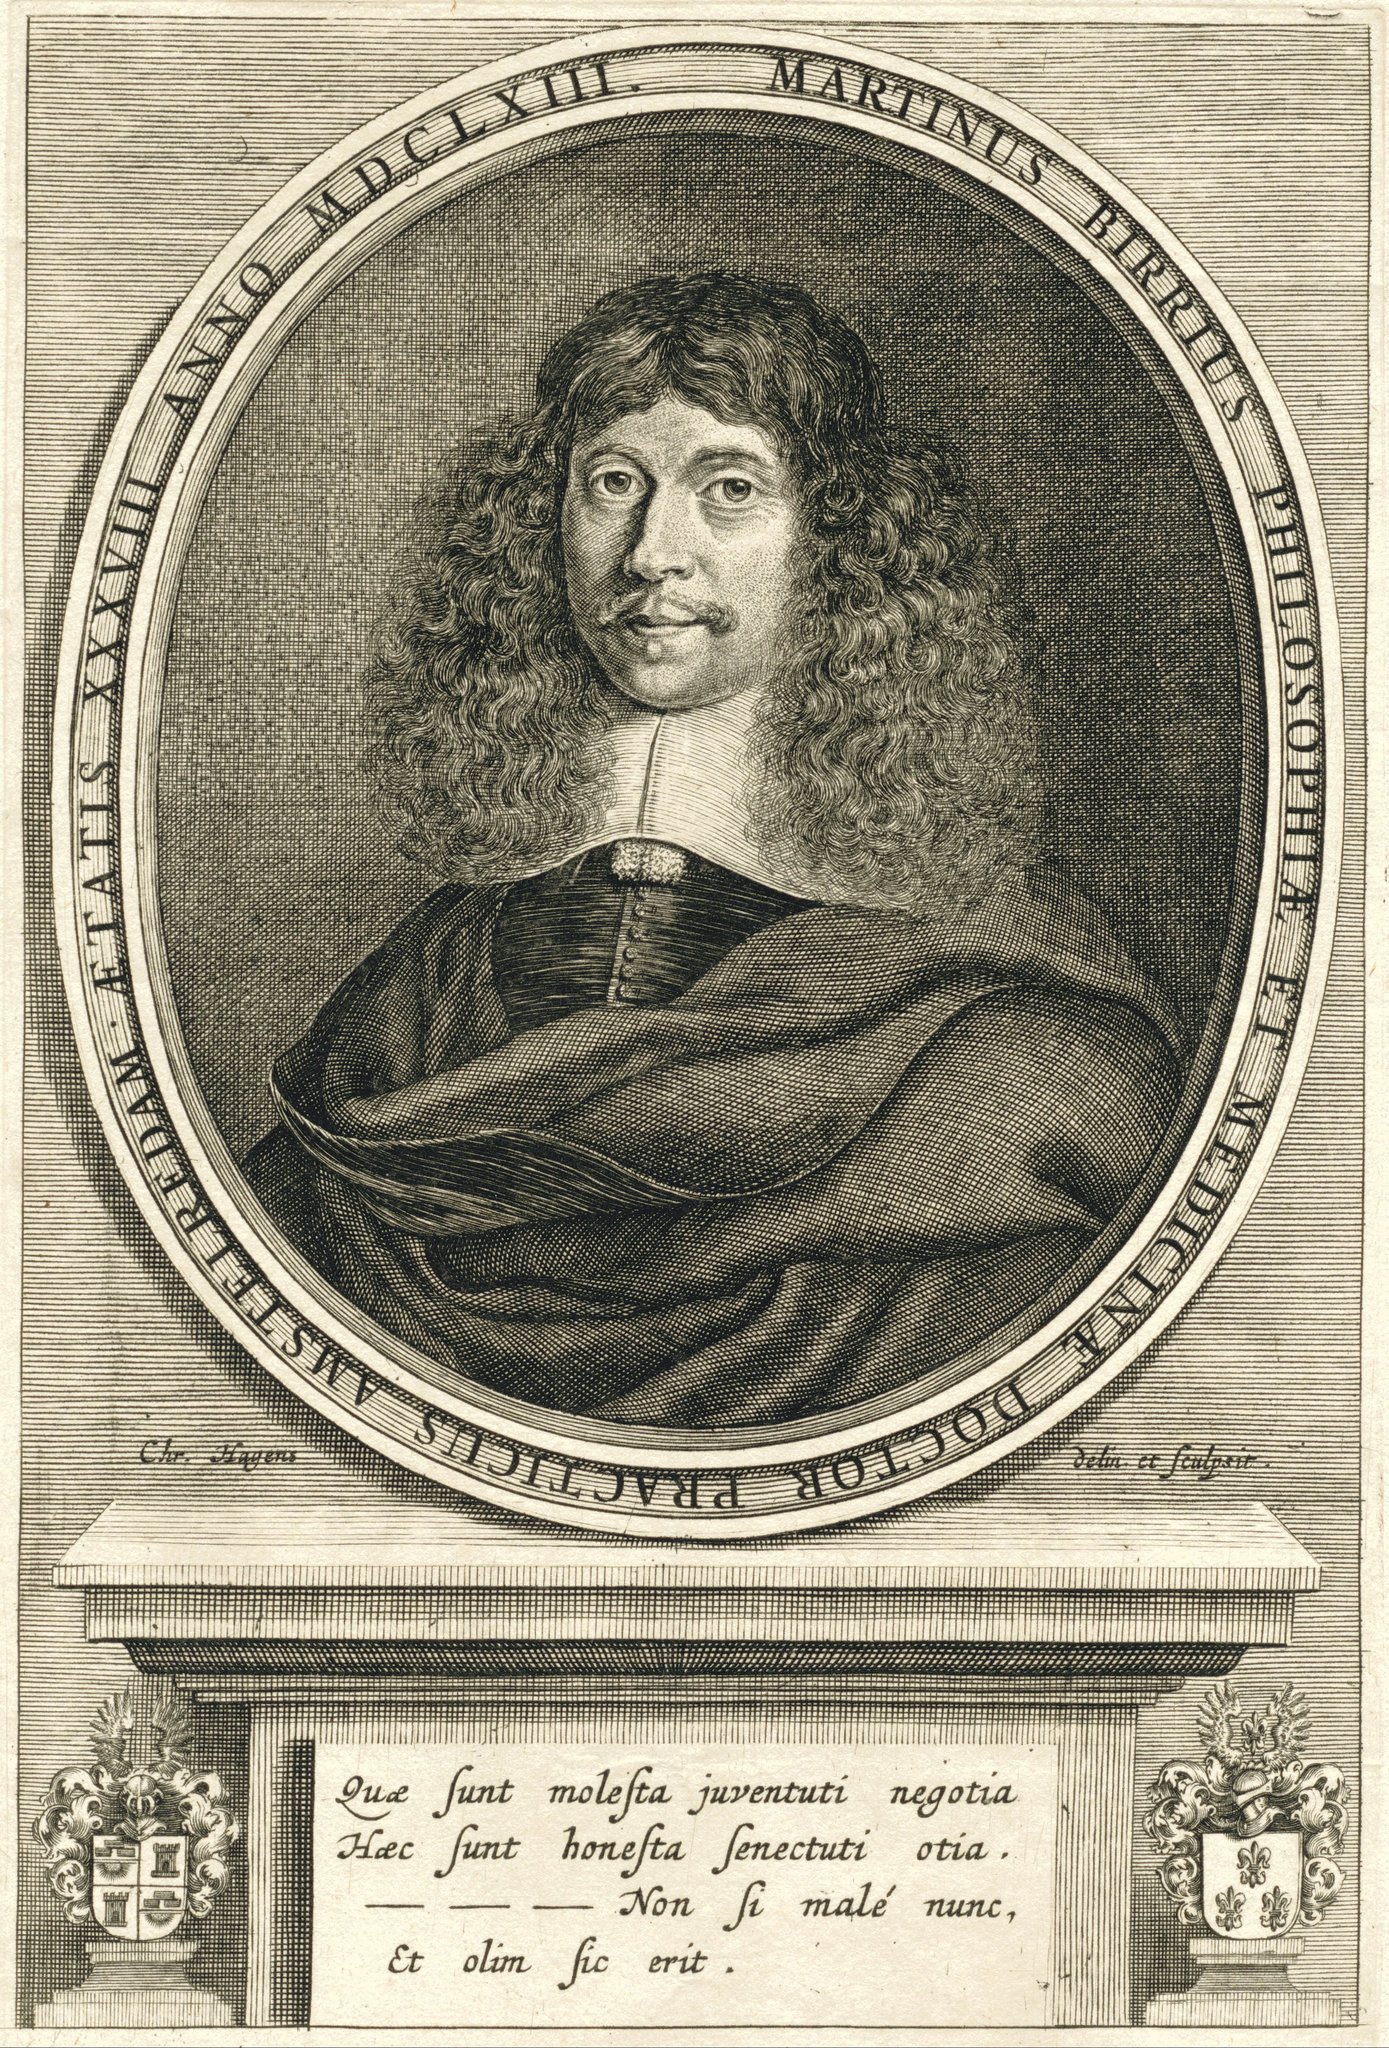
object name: print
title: Portret van Martin Birrius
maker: christiaan hagen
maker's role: draughtsman, print maker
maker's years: 1635-1707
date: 1663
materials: paper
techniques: engraving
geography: amsterdam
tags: moustache, armorial bearing, heraldry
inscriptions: collector's mark: Lugt 2228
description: Buste naar links van de filosoof en arts Martin Birrius, in 1663, 38 jaar oud. Afgebeeld in een ovaal, met onder zijn portret een plint met een vierregelige tekst in Latijn, aan weerszijden hiervan een wapen op een piëdestal.